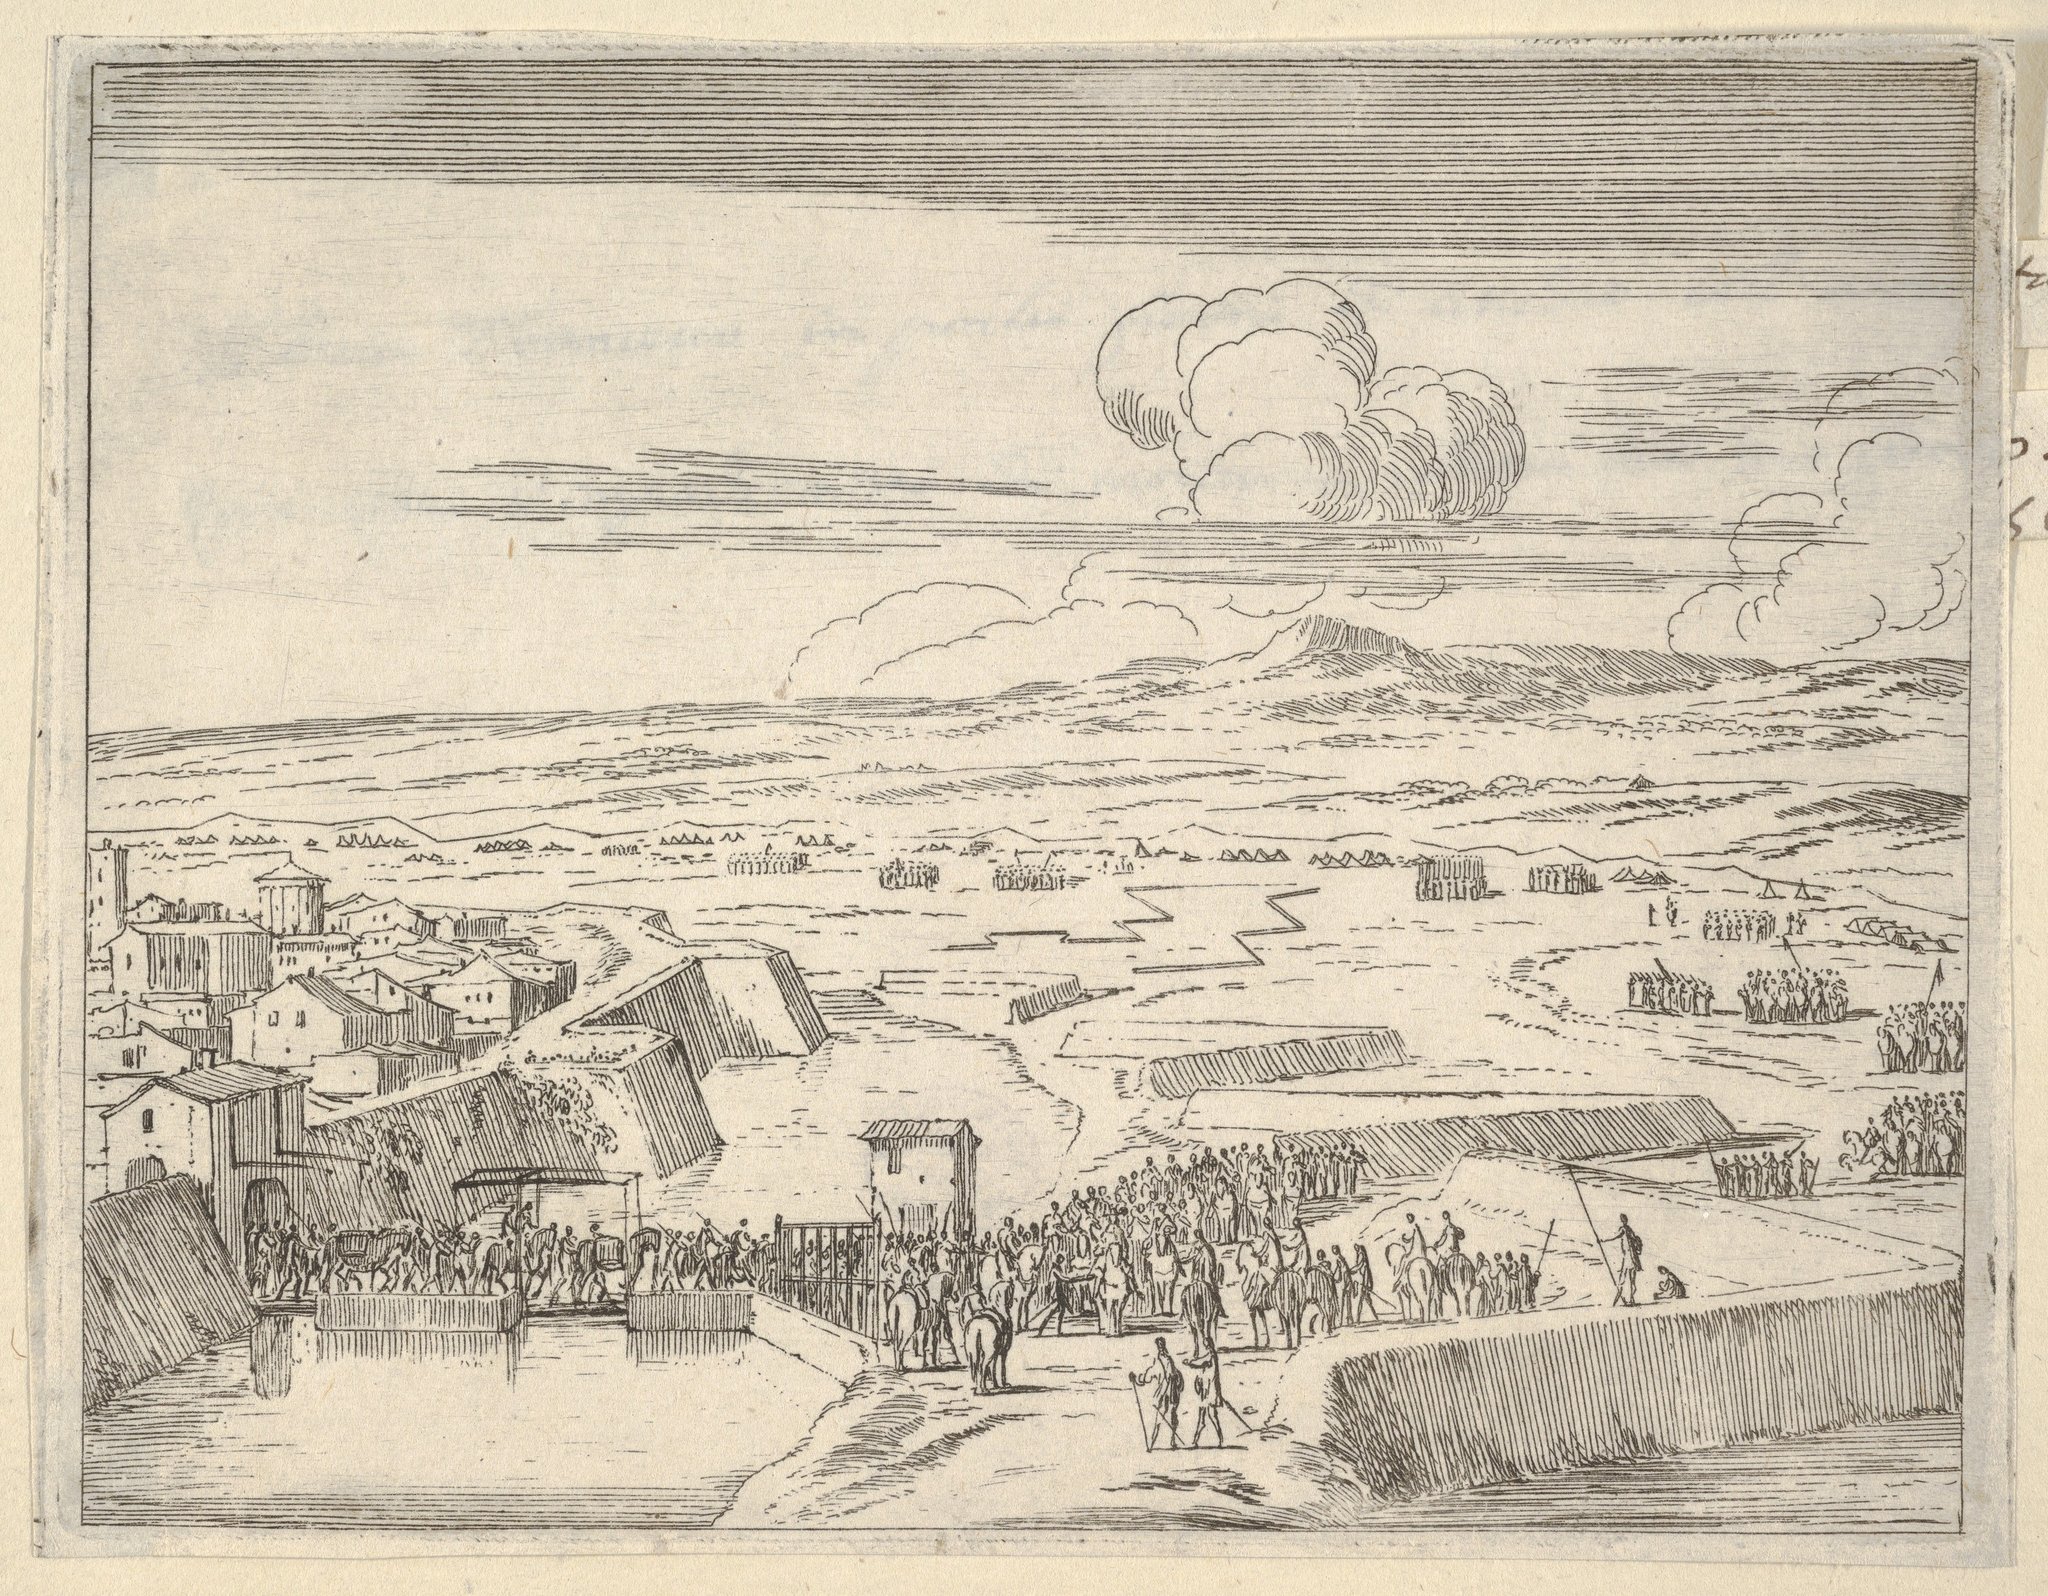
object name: print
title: After a Few Days of Seige with the French Army, Francesco I d'Este Takes Prossession of Mortara, The Last of his Great Victories, from "L'Idea di un Principe ed Eroe Cristiano in Francesco I d'Este, di Modena e Reggio Duca VIII [...]"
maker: bartolomeo fenice (fénis)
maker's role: artist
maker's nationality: italian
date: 1659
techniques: etching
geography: italy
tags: buildings,army,horses